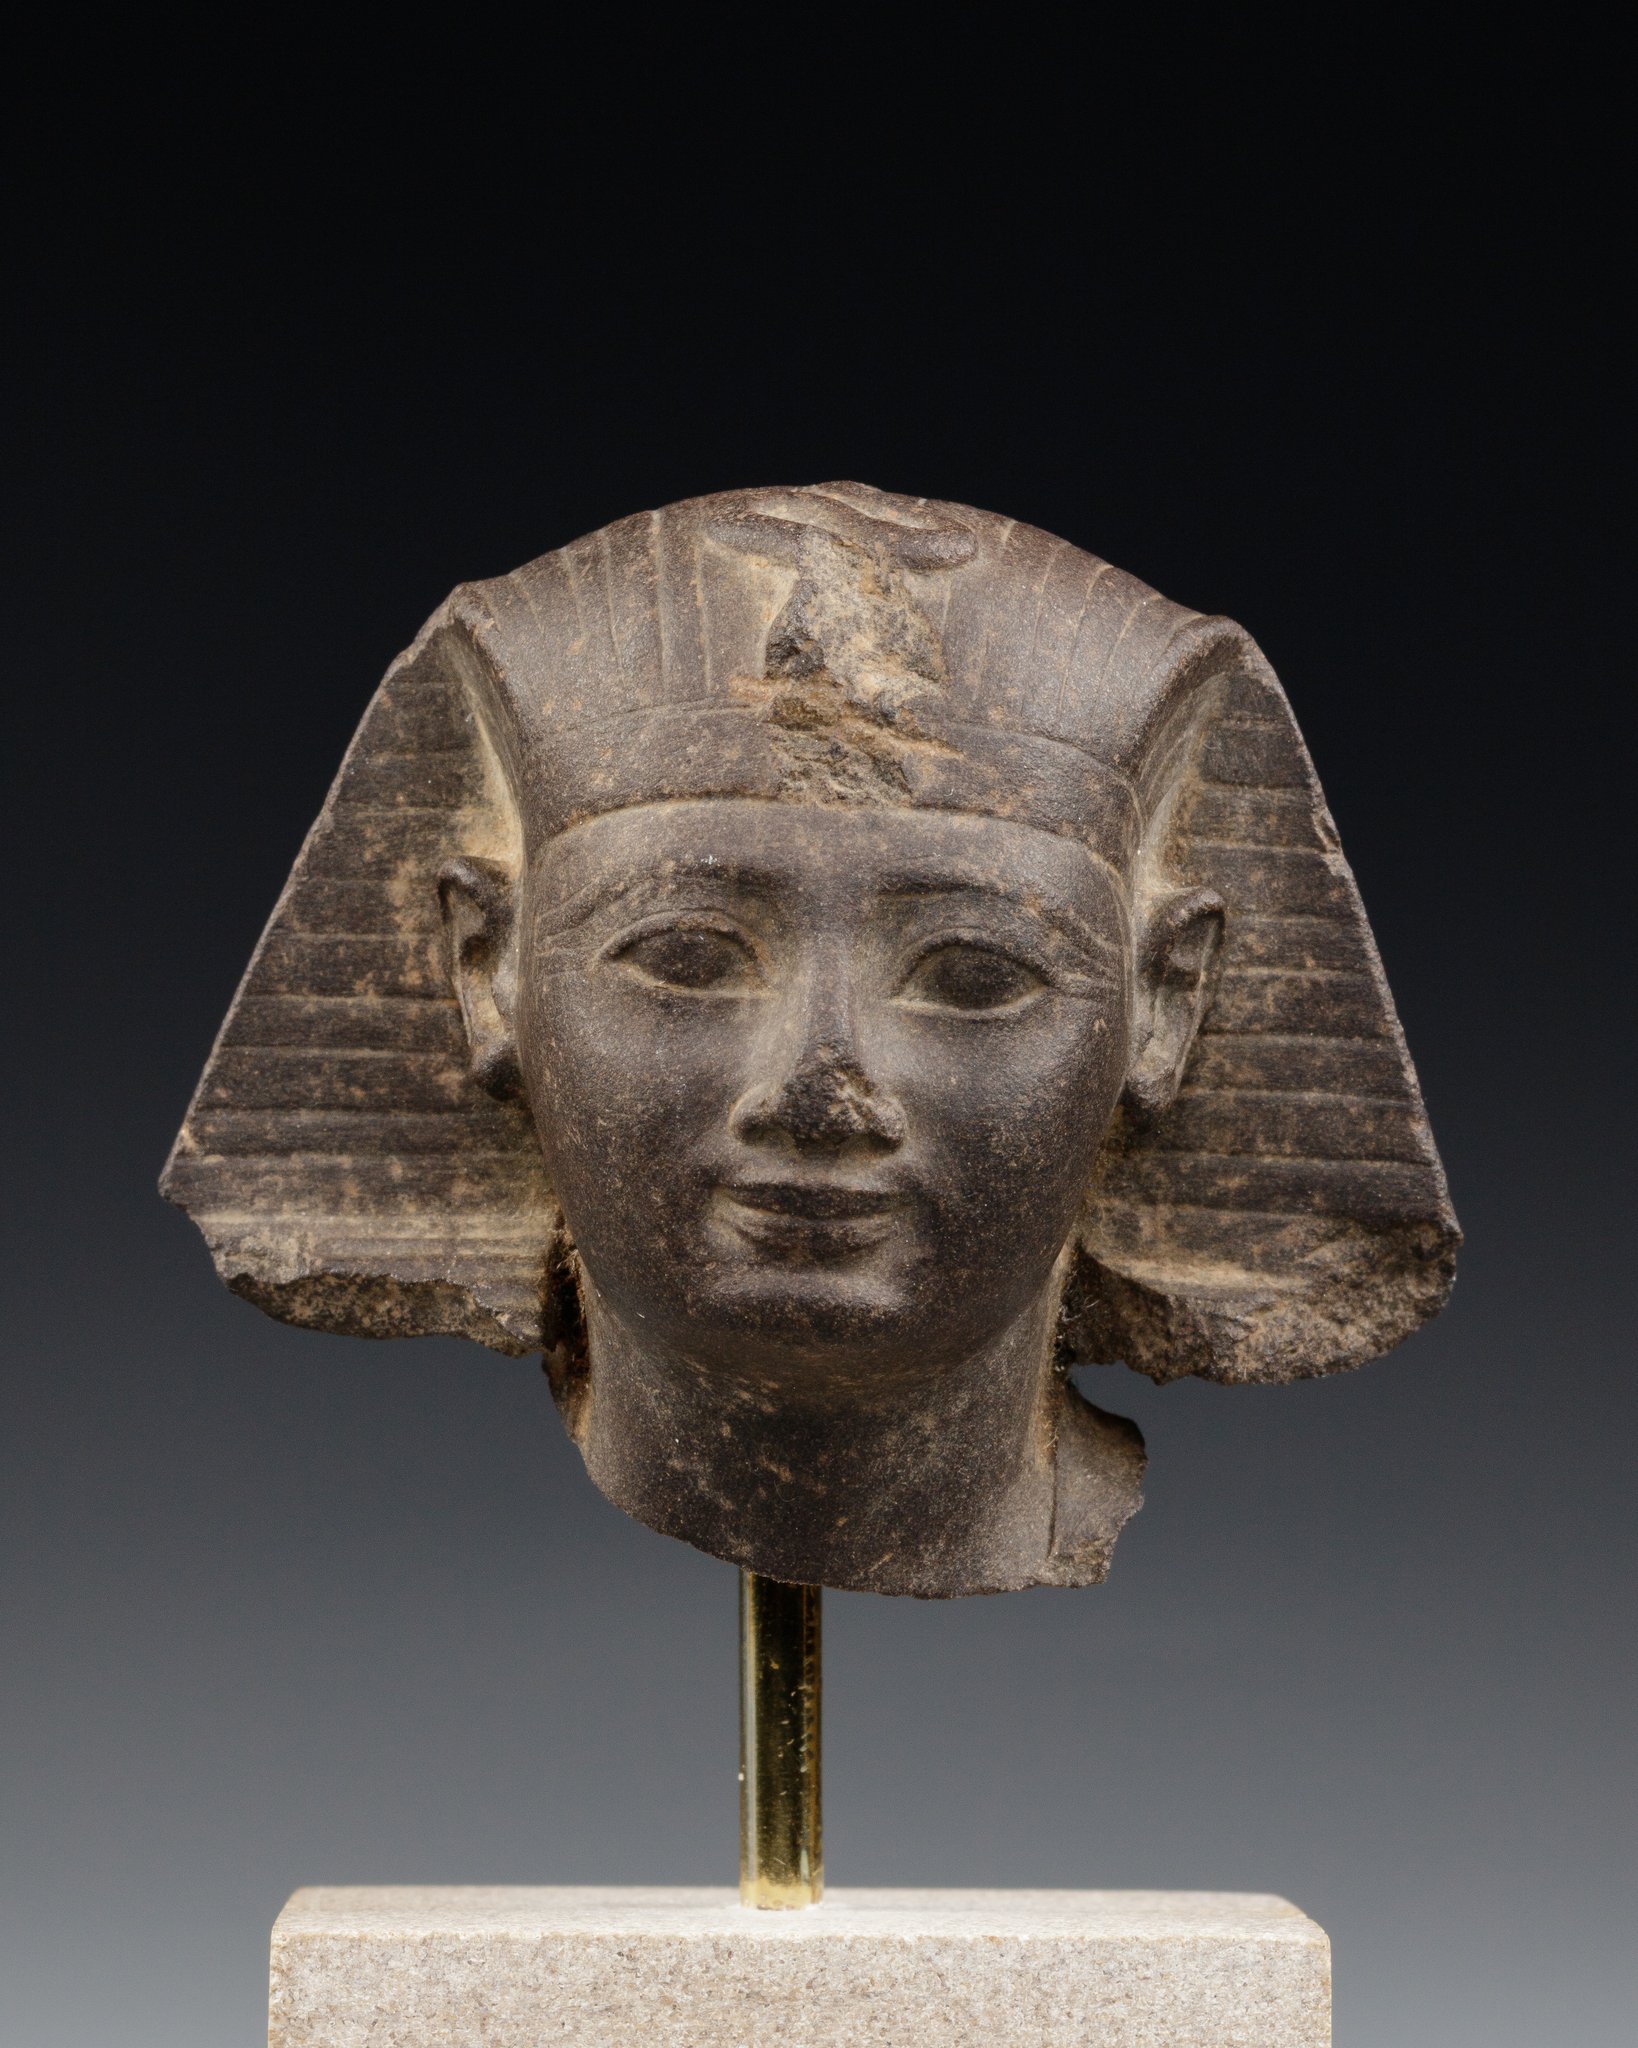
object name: head, king, statuette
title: Head from the Statuette of a King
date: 1479-1458 BCE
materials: stone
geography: egypt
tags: kings,heads